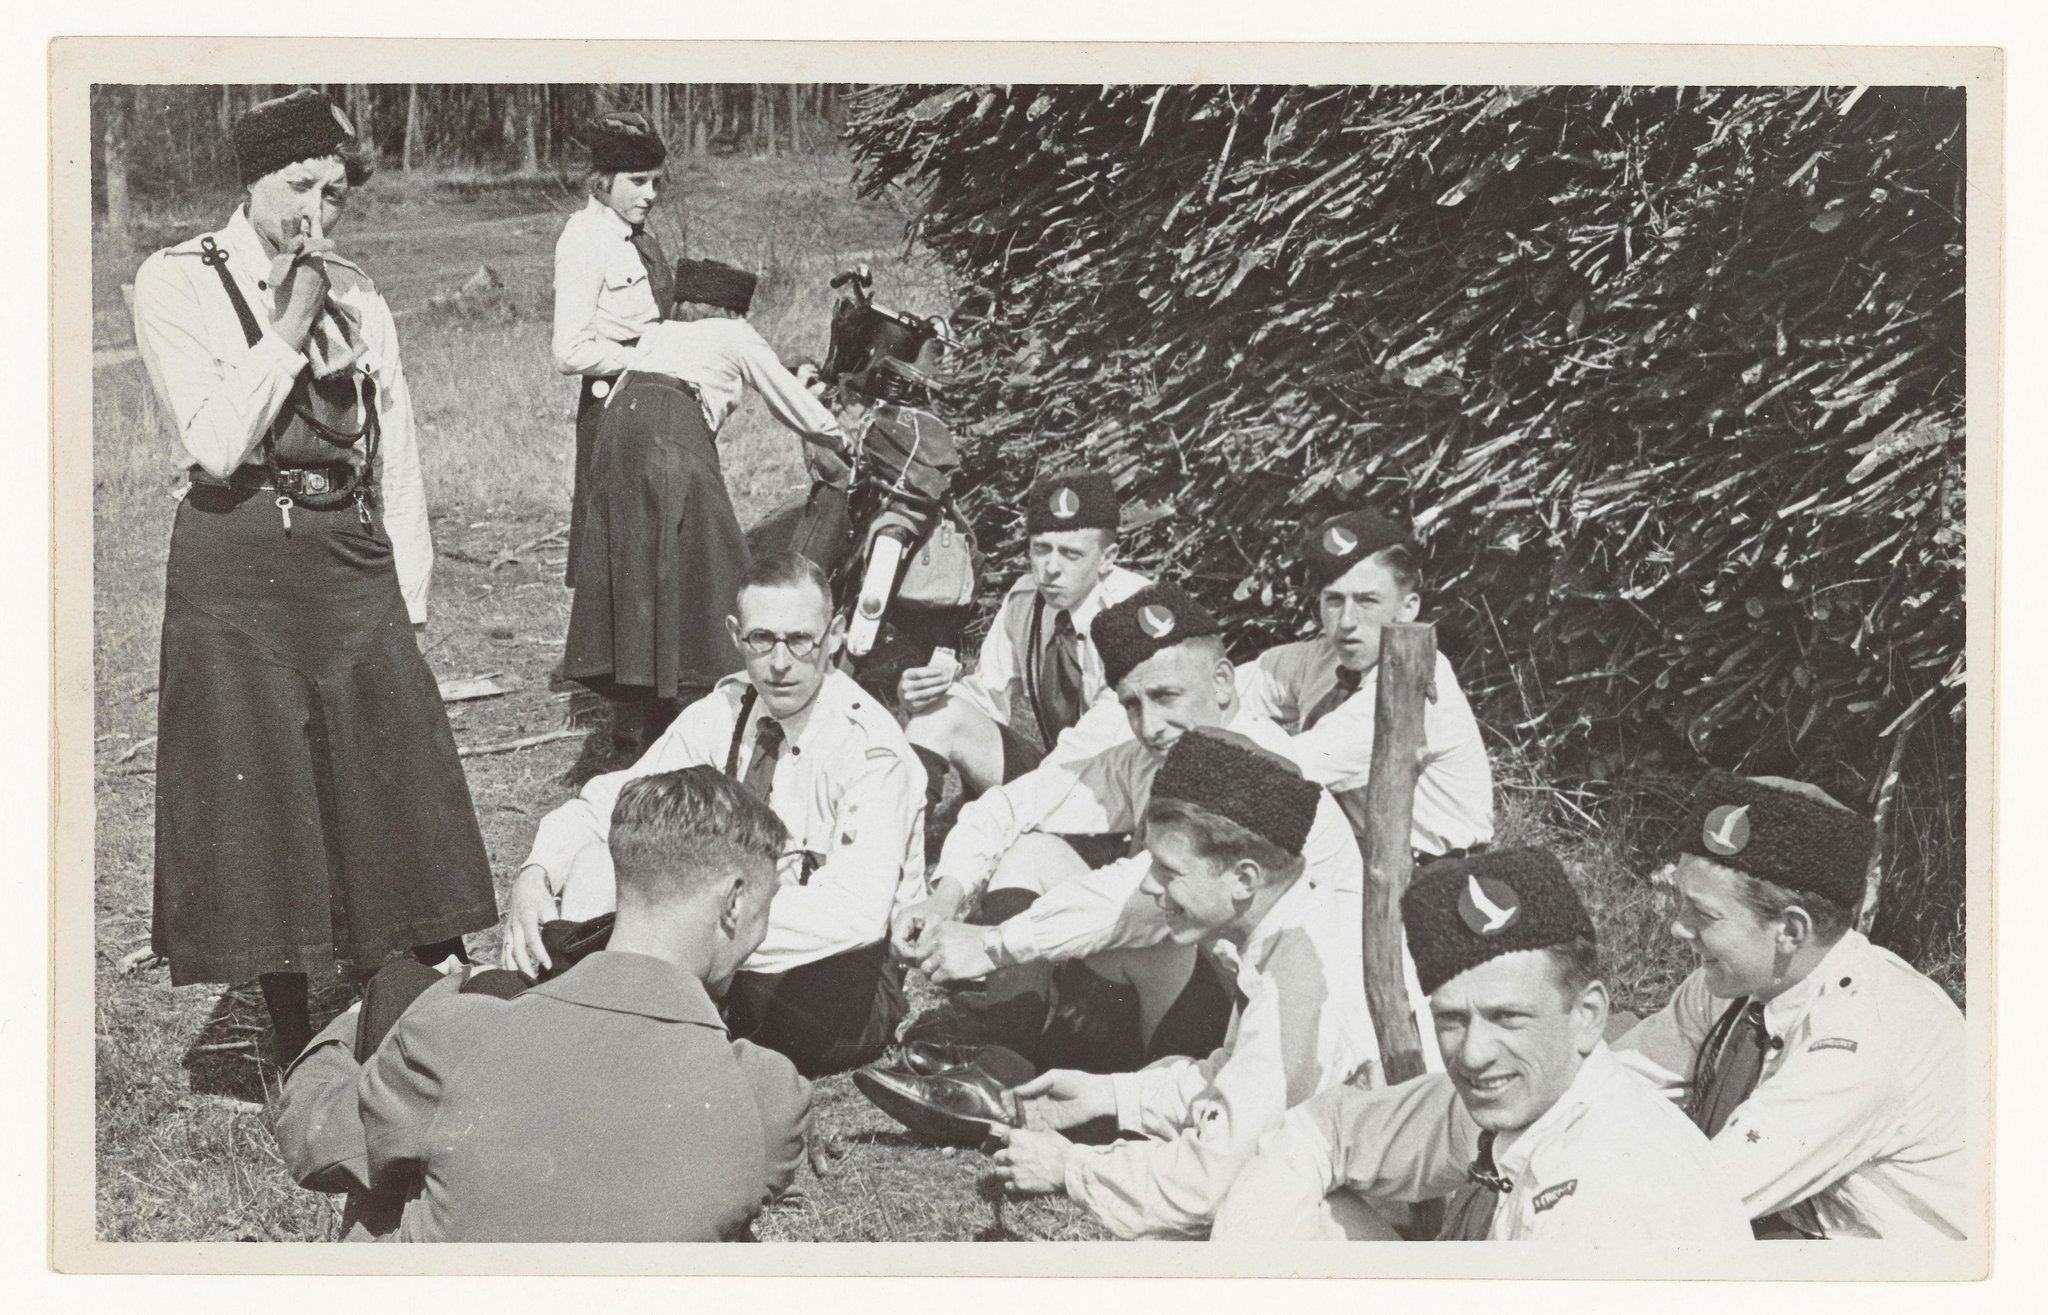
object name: photograph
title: Na afloop van de optocht Jeugdstorm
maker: j. otto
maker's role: fotograaf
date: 1935-1937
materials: photographic support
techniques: gelatin silver print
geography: zeist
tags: military parade, pageant, zeist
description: In een bosachtige omgeving rusten leden van de Jeugdstorm in uniform uit, vermoedelijk na afloop van de optocht. De stormer rechts vooraan heeft op zijn mouw het woord 't Sticht staan. Alle afdelingen hadden een naam, deze zijn lid van Gewest 't Sticht, wat stond voor Zeist en omgeving. De man achter hem: Amersfoort. De staande vrouw met nestels eet en banaan. De man met bril op de grond is waarschijnlijk de amateurfotograaf J. van S. Op de achtergrond een houtstapel.